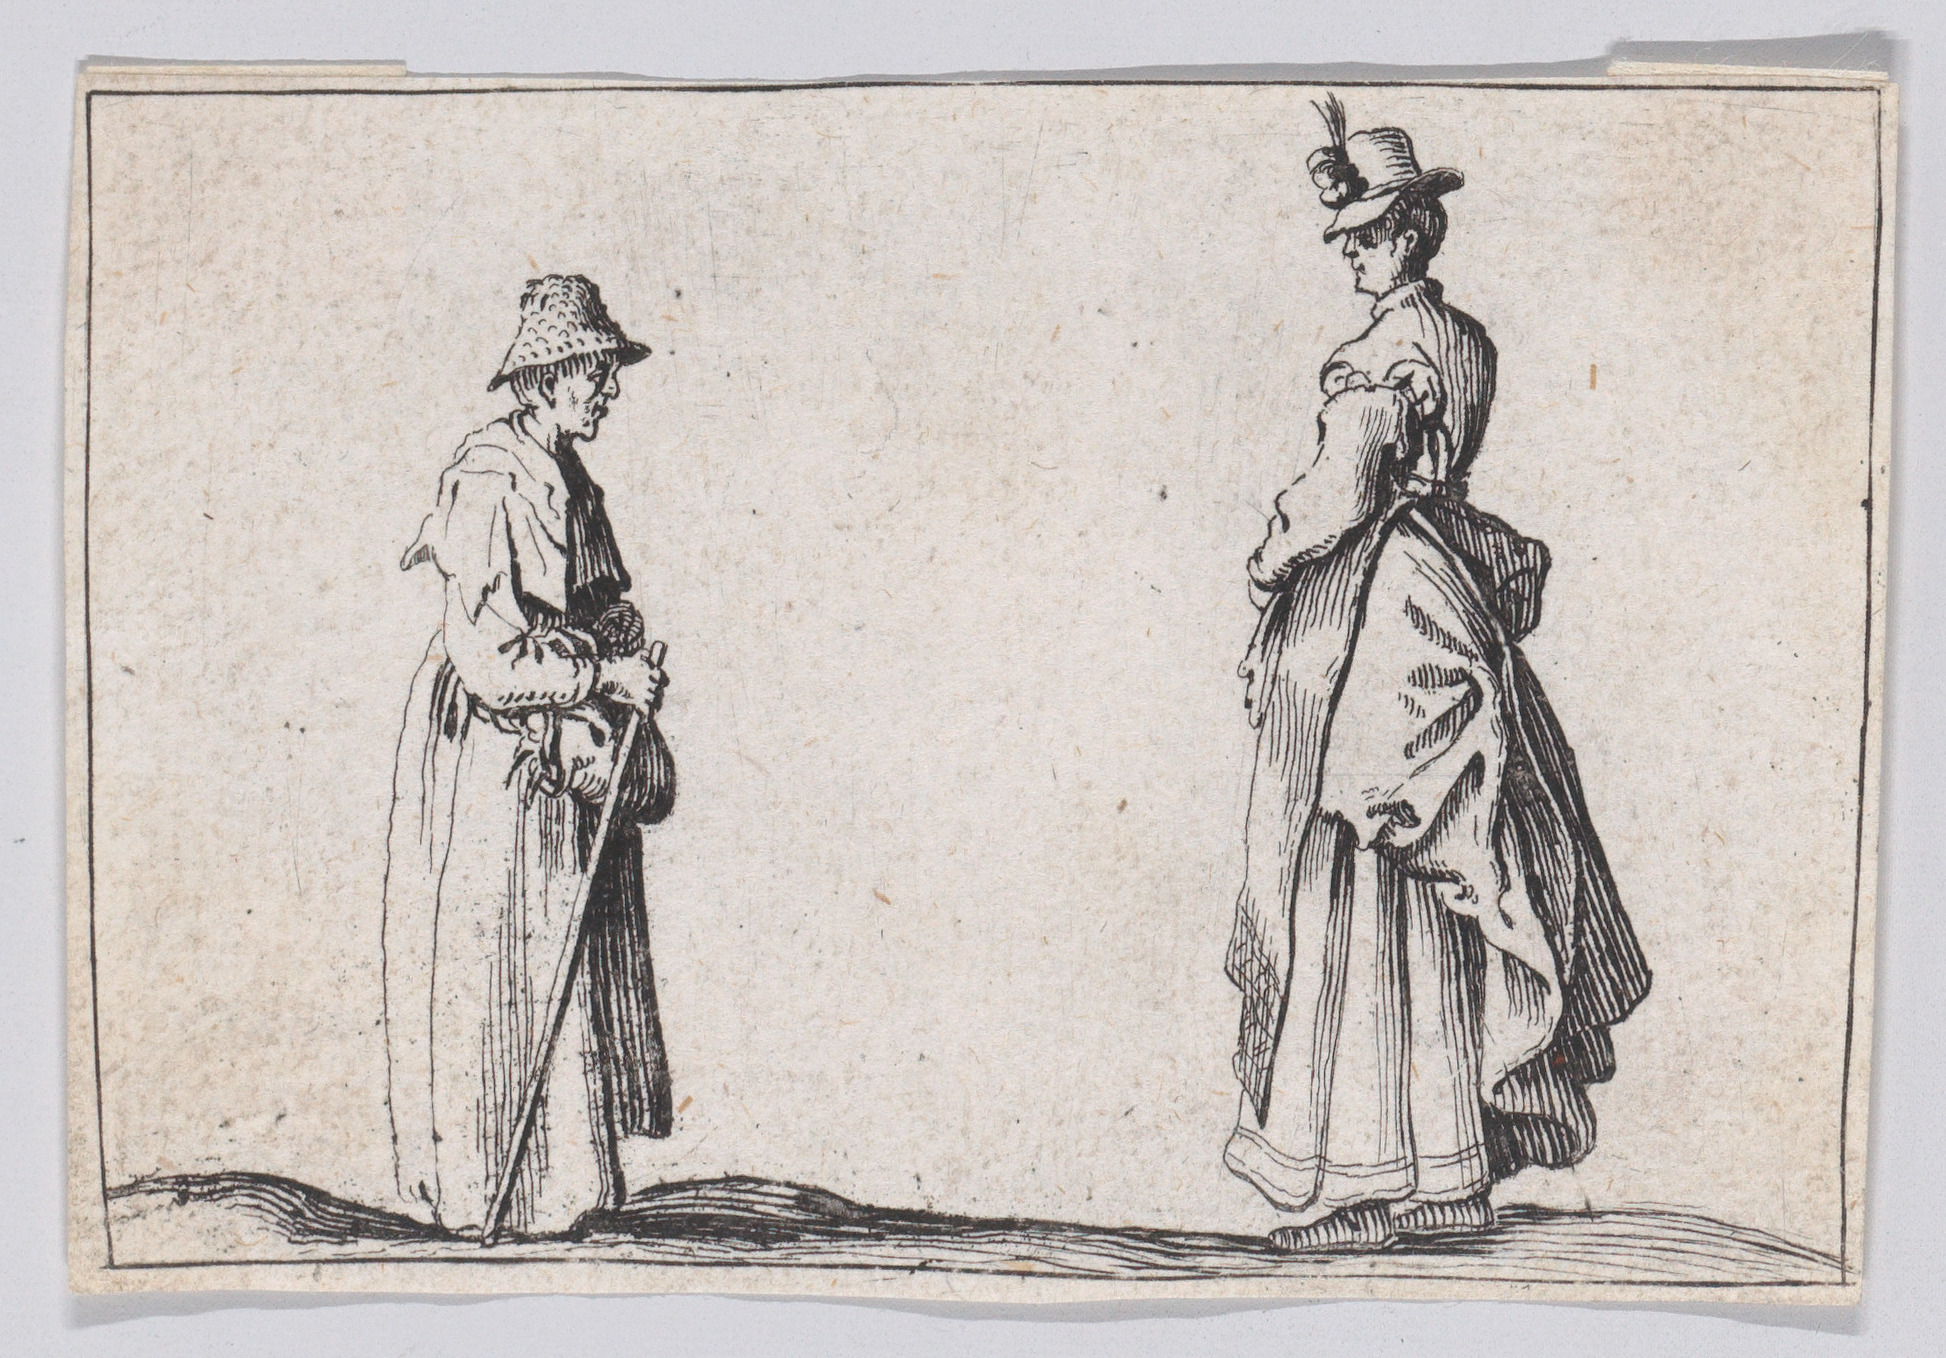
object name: print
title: Copy of Deux Femmes de Profil (Two Women in Profile), from "Les Caprices"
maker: Anonymous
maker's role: artist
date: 1601-1700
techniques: etching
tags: women